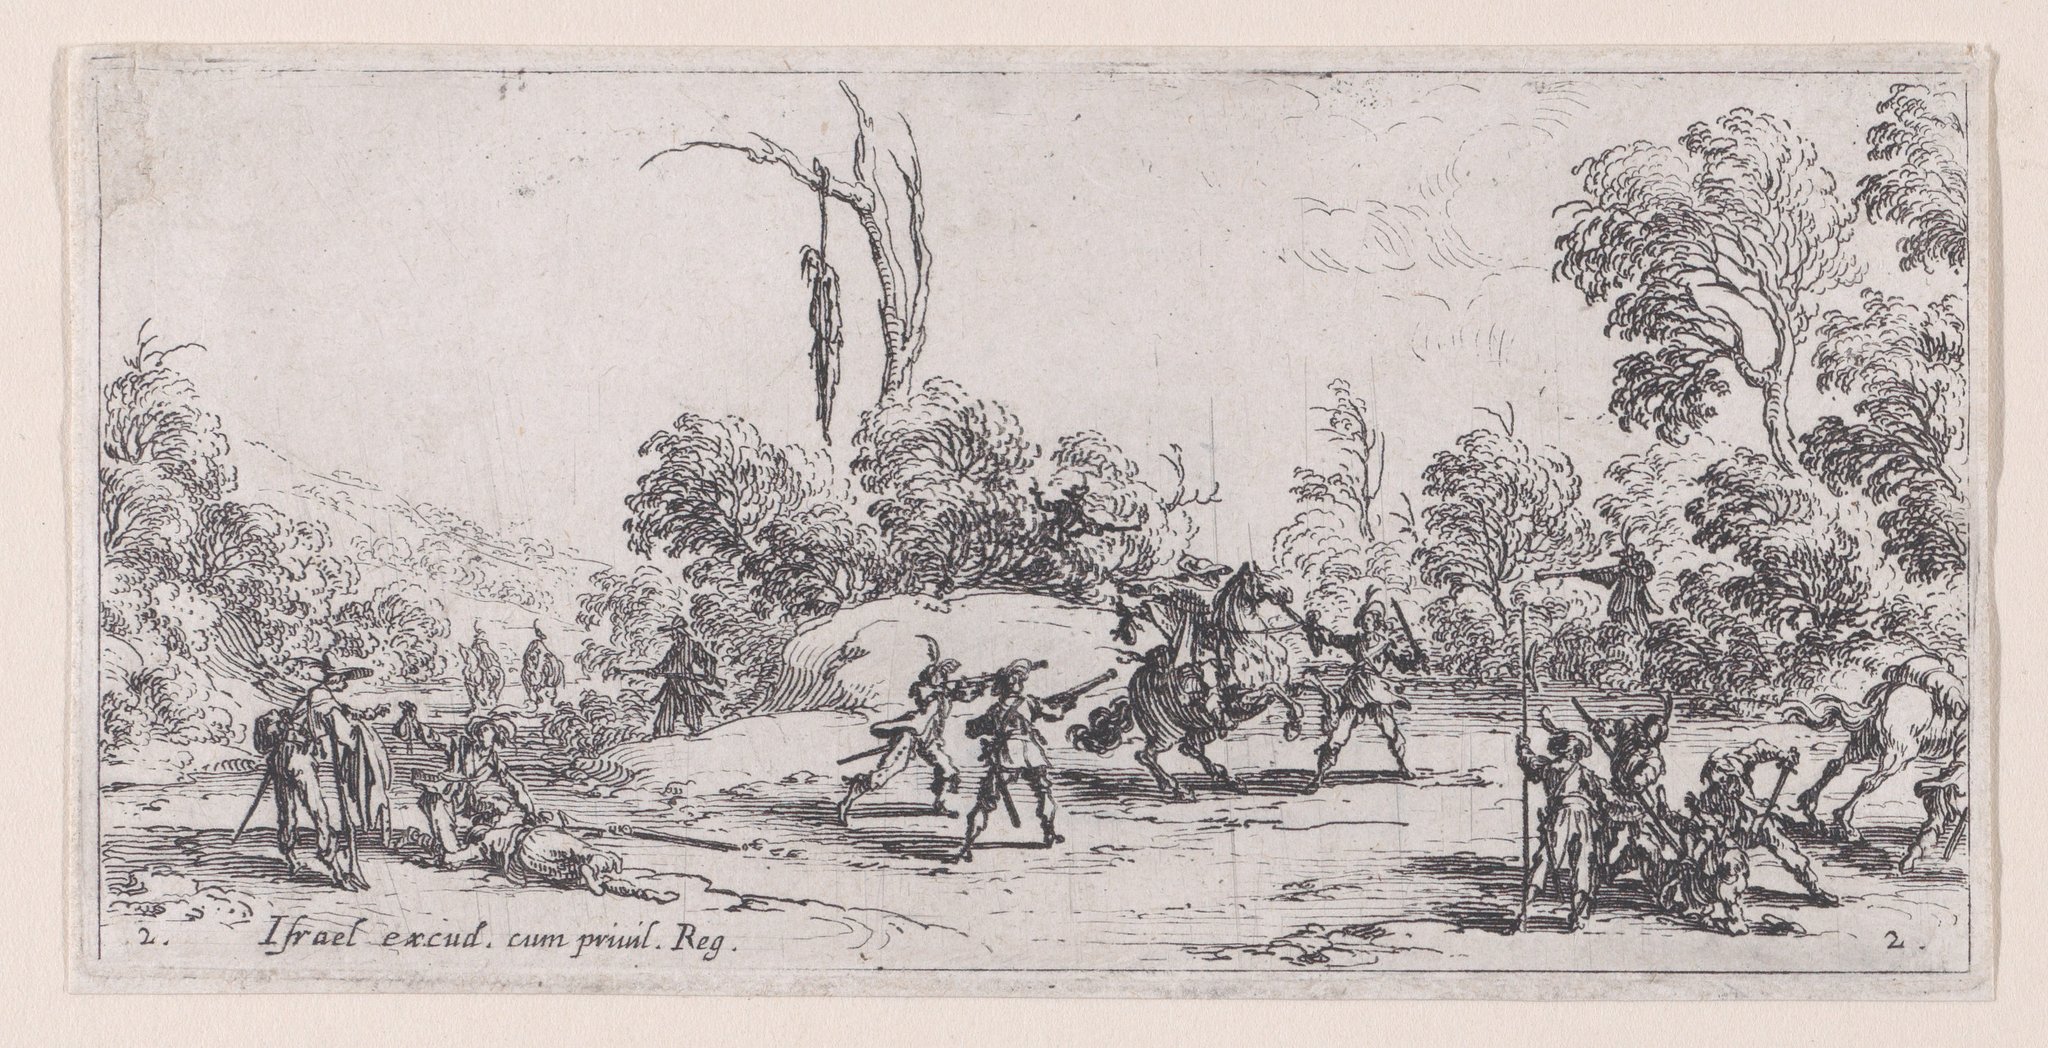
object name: print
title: L'Attaque sur la Route estampe appelée aussi Vol Sur Les Grands Chemins (Attack on Route, also called Theft on the Great Road), plate 2 from "Les Petites Misères de la Guerre" (The Little Miseries of War)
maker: jacques callot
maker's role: artist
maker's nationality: french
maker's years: 1592-1635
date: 1636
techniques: etching